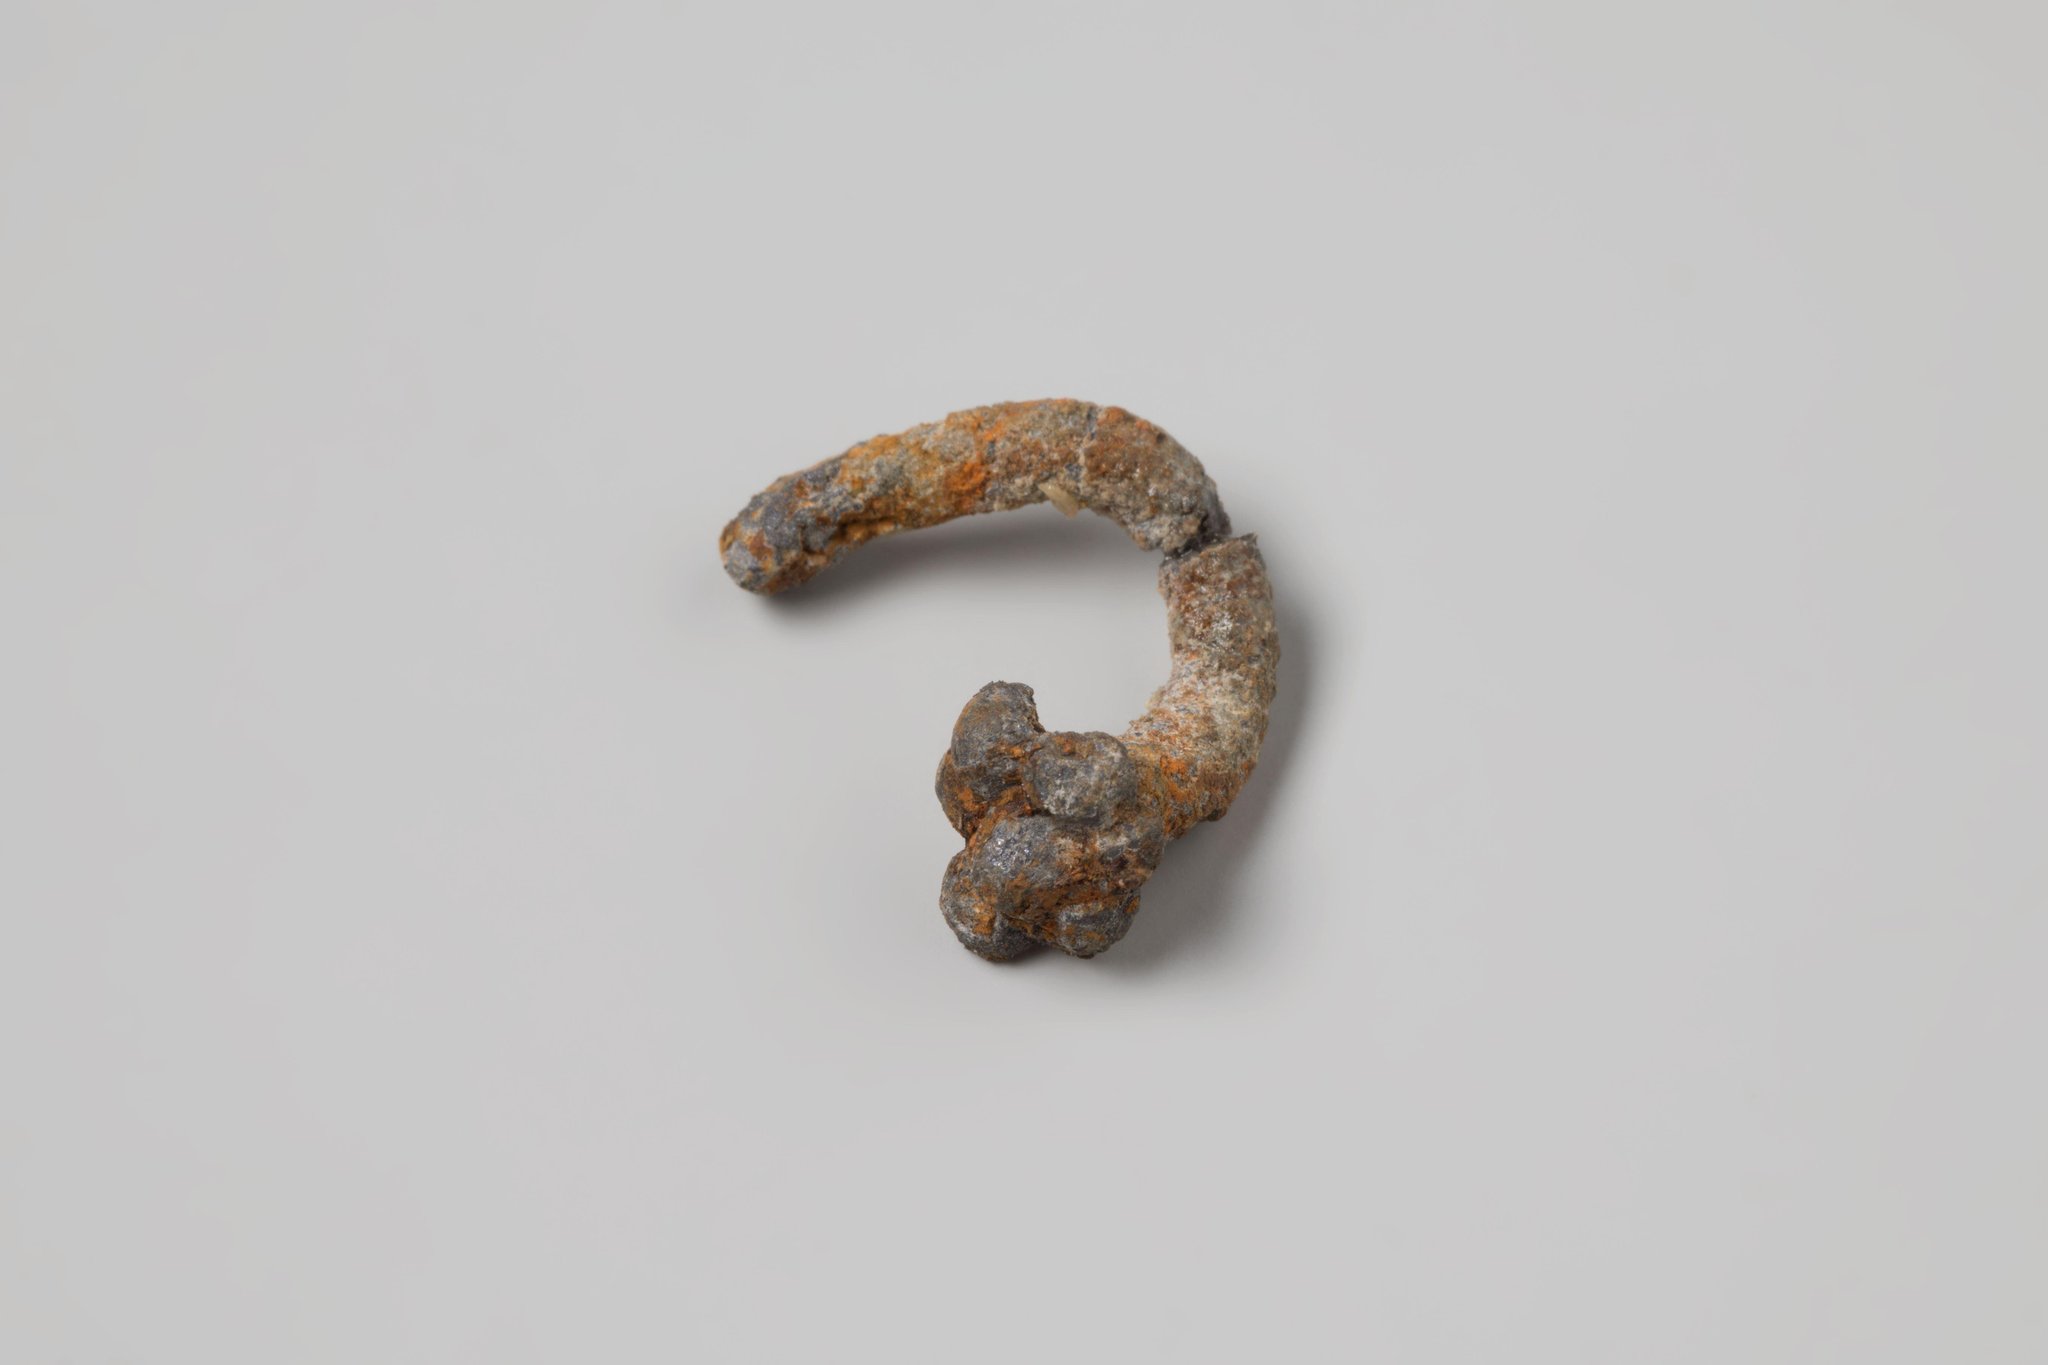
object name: beslag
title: Decoratief beslag uit het wrak van de Oost-Indiëvaarder Hollandia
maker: Anonymous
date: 1700-1743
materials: tin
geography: netherlands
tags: verenigde oostindische compagnie, hollandia (schip), annet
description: Fitting, decorative fitting or fragment; id. NG 1980-27H3353, squashed.